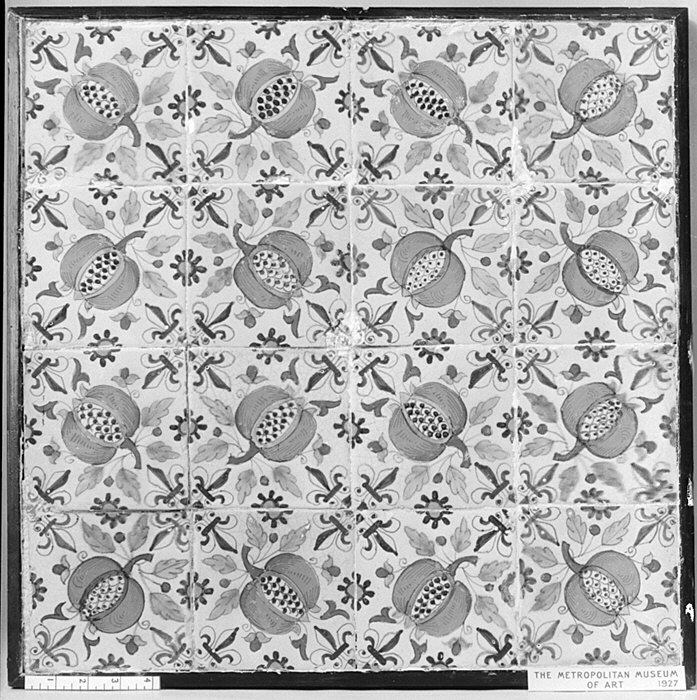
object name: tile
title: Tiles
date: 1620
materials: earthenware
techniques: glazing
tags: flowers